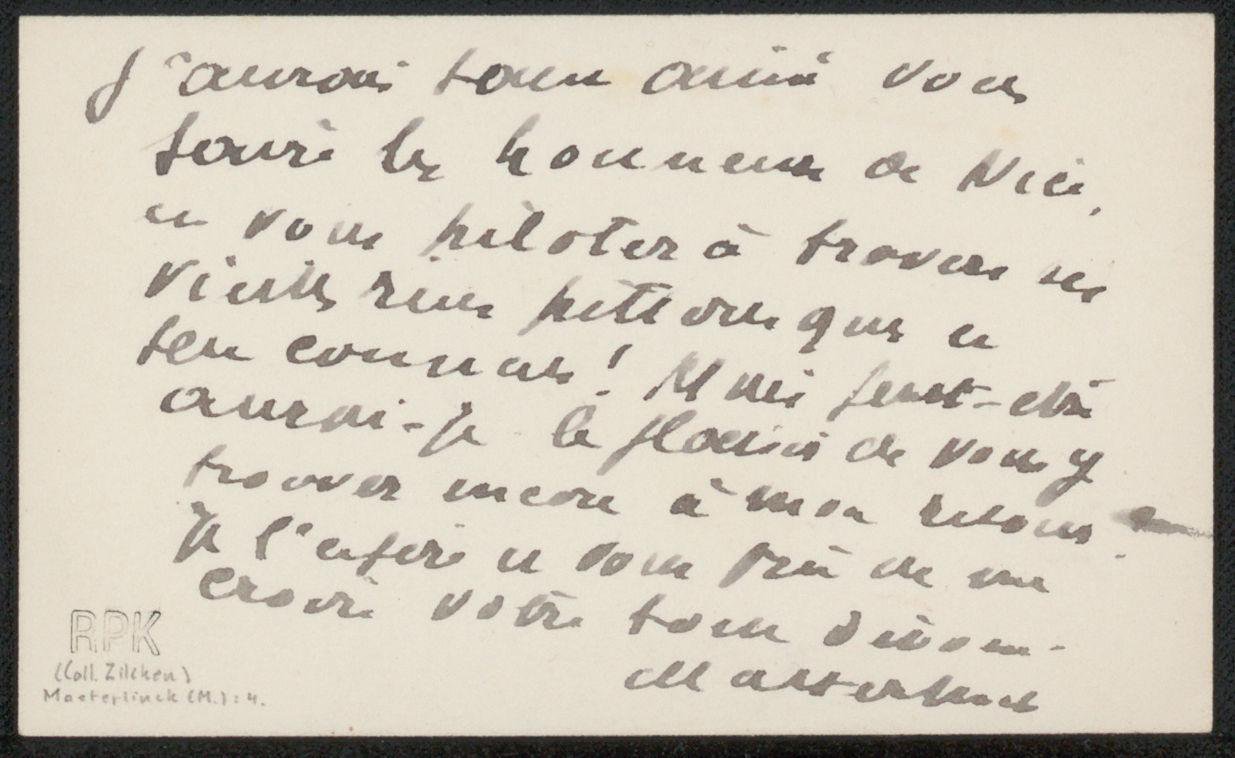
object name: visiting card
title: Visitekaartje aan Philip Zilcken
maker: maurice maeterlinck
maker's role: dichter, essayist, toneelschrijver, vertaler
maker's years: 1862-1949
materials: cardboard, ink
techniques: pen, printing, writing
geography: paris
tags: the hague, draughtsman, philip zilcken, paris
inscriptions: collector's mark: ‘RPK’